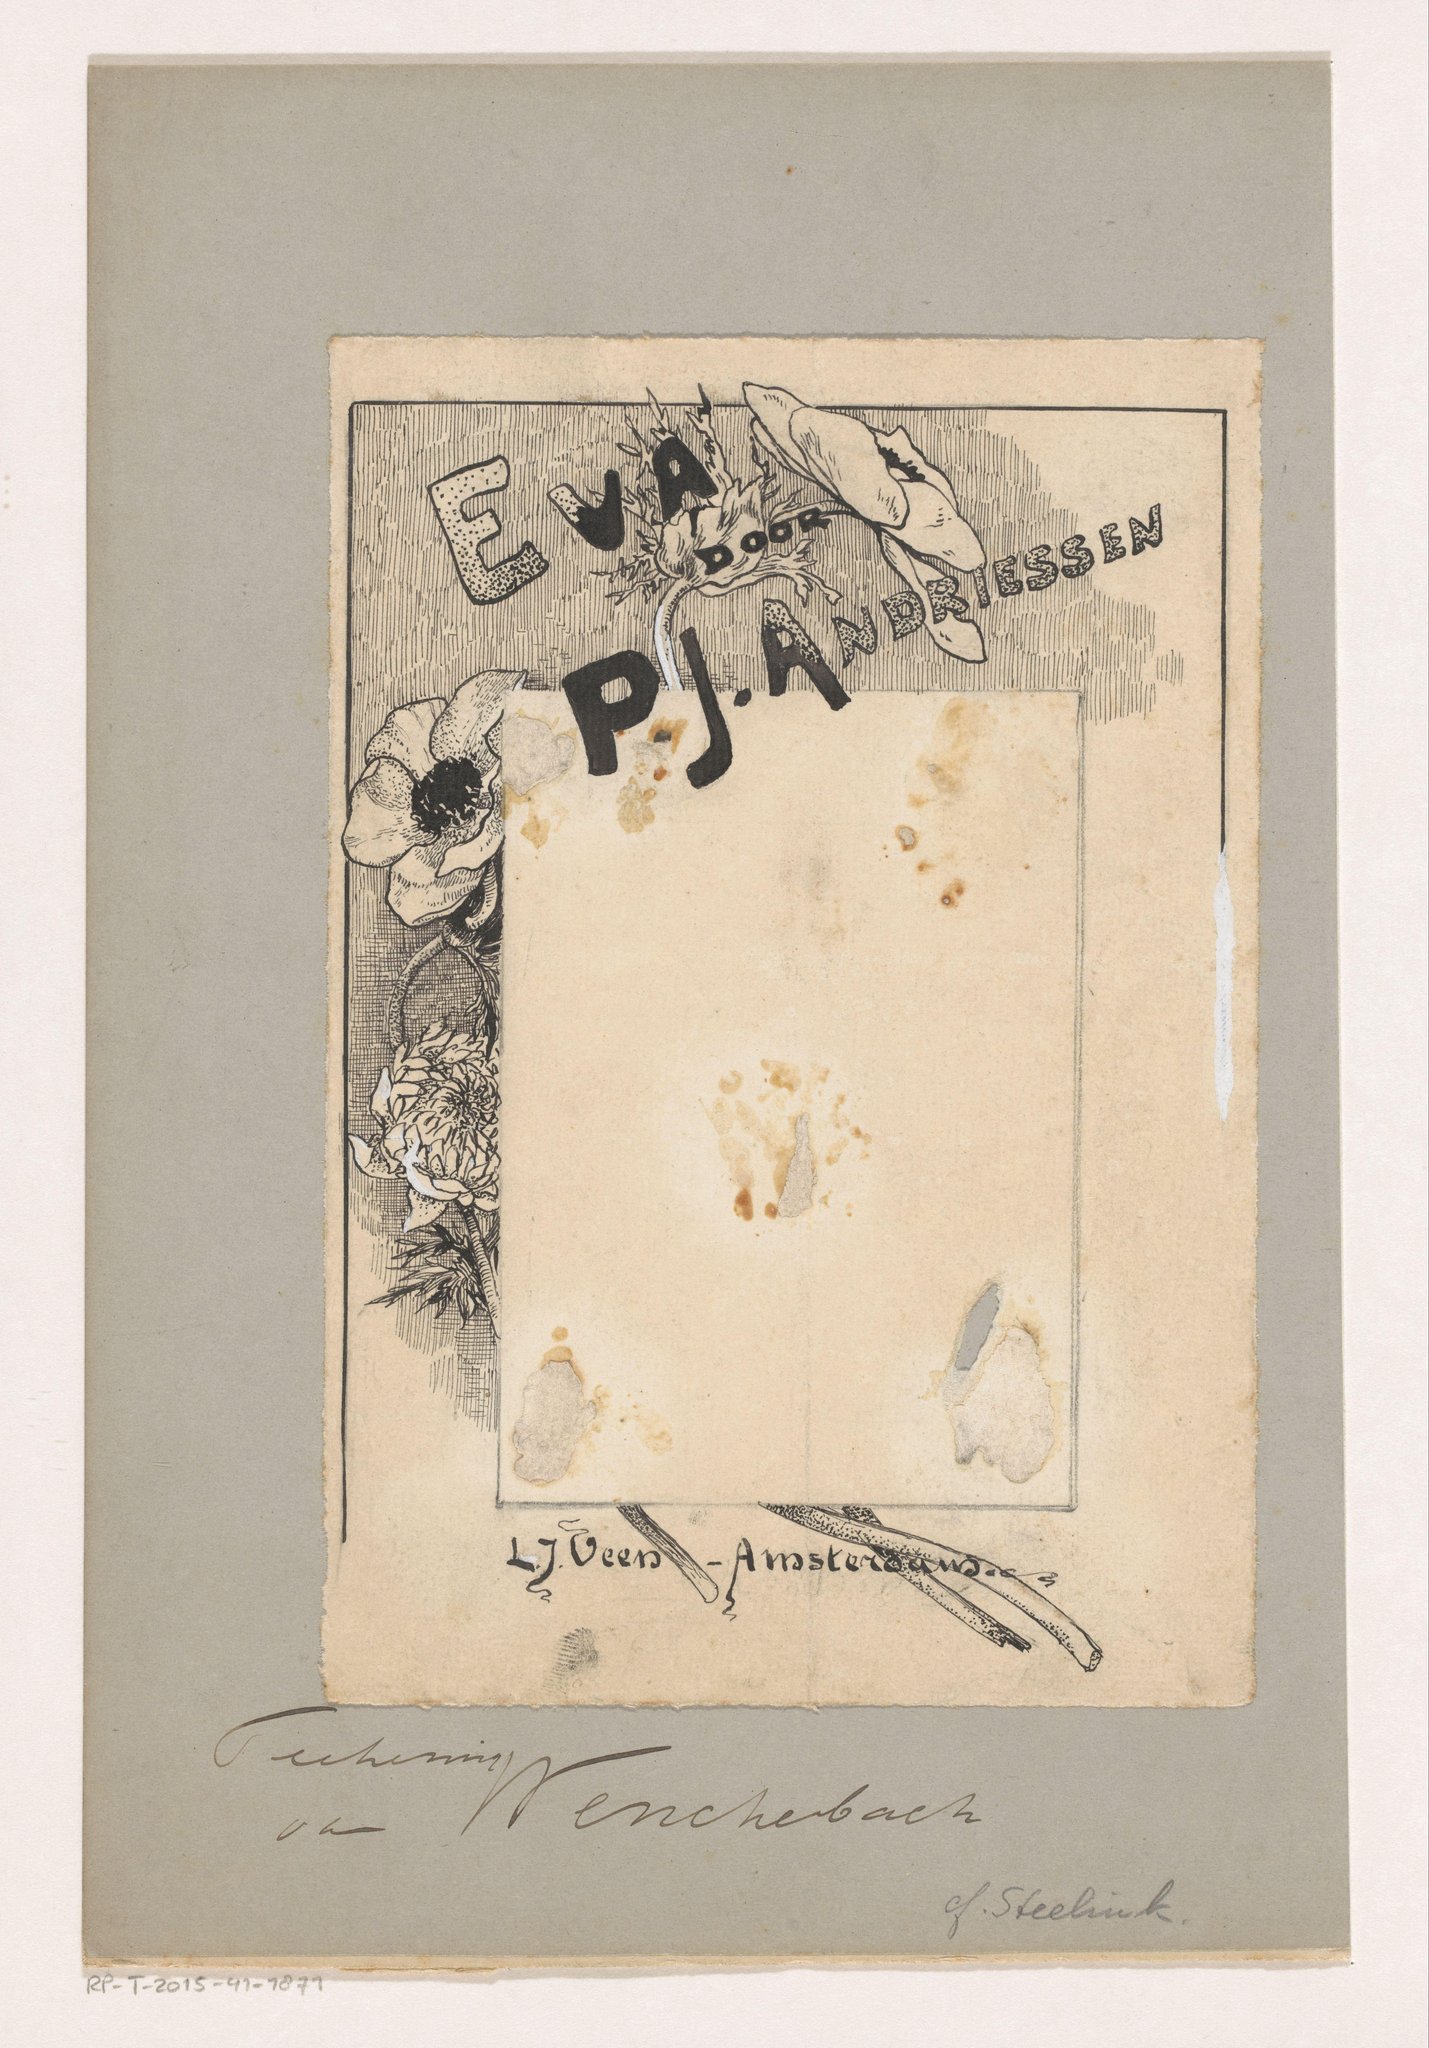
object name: study for binding design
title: Bandontwerp voor: P.J. Andriessen, Eva, 1893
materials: cardboard, paint, ink, paper, pencil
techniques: brush, pen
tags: flowers ~ ornament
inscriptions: annotation: ‘Teekening/ van Wenckebach/ of Steelink’, collector's mark: Lugt 2228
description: Bloeiende bloemen en de boektitel en auteursnaam rond een blanco rechthoekig kader.